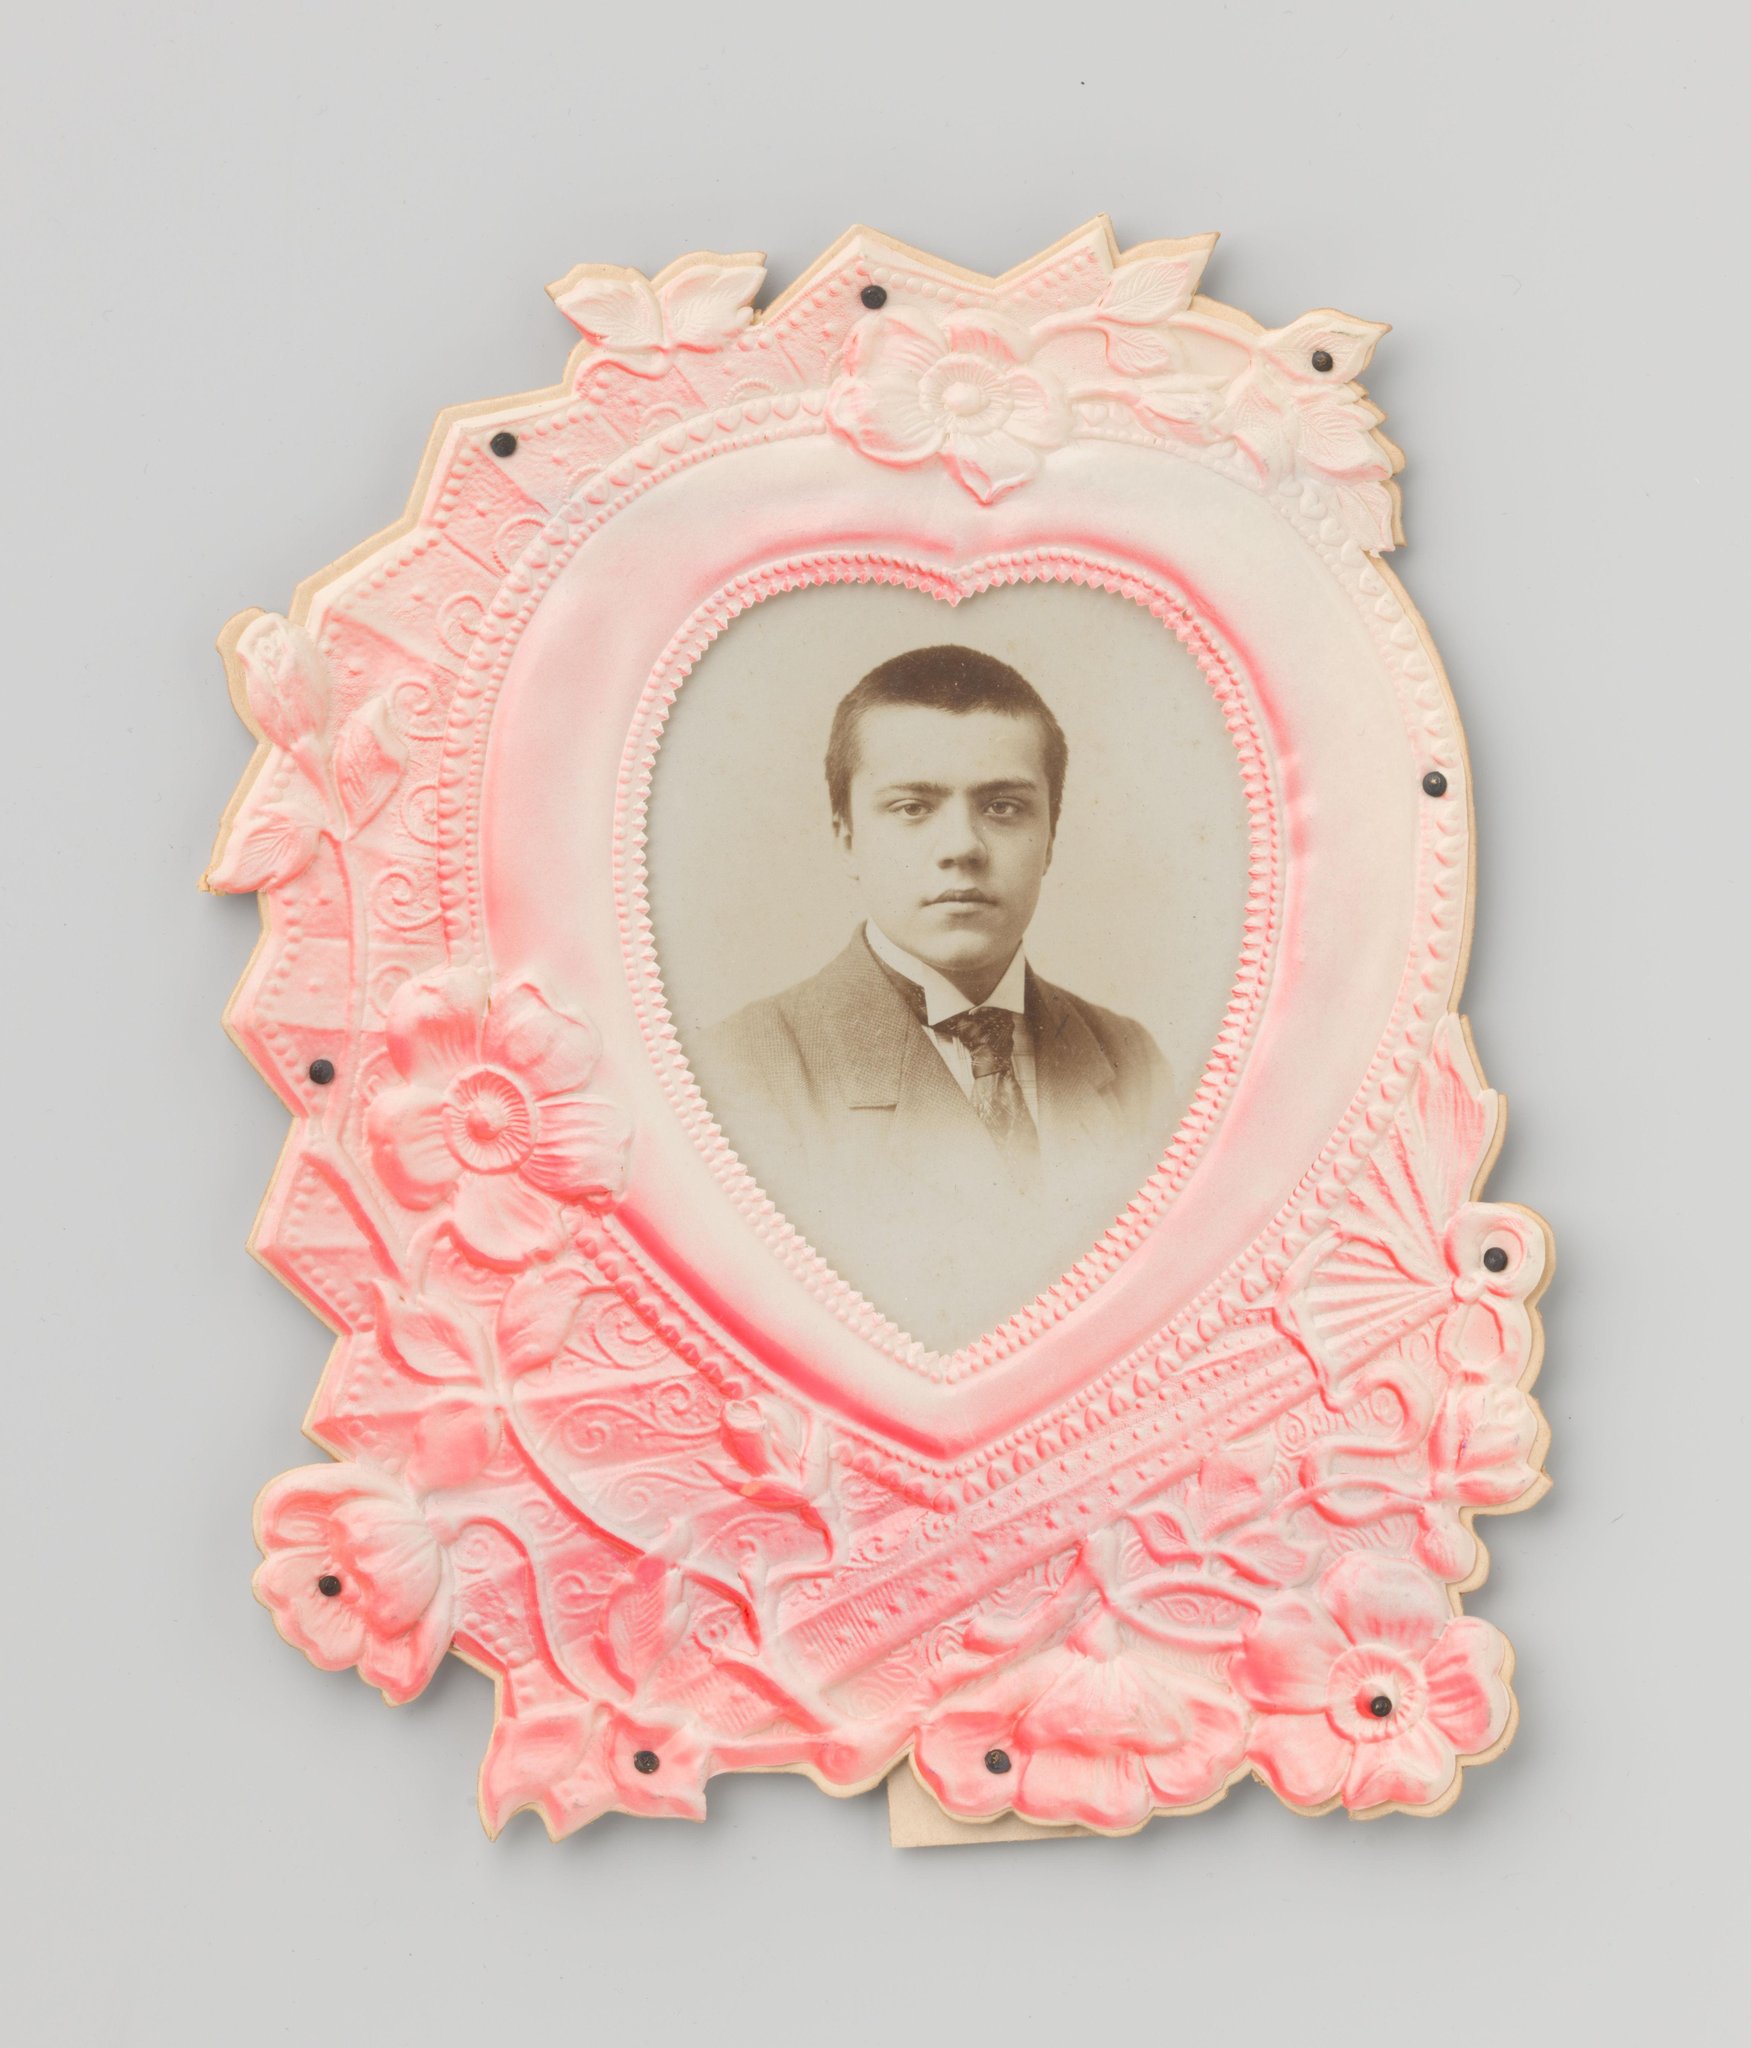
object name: frame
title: Portret van een onbekende jonge man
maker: Anonymous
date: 1880-1900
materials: paper, cardboard, glass, metal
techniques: collodion silver print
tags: youth, adolescent, anonymous historical person portrayed